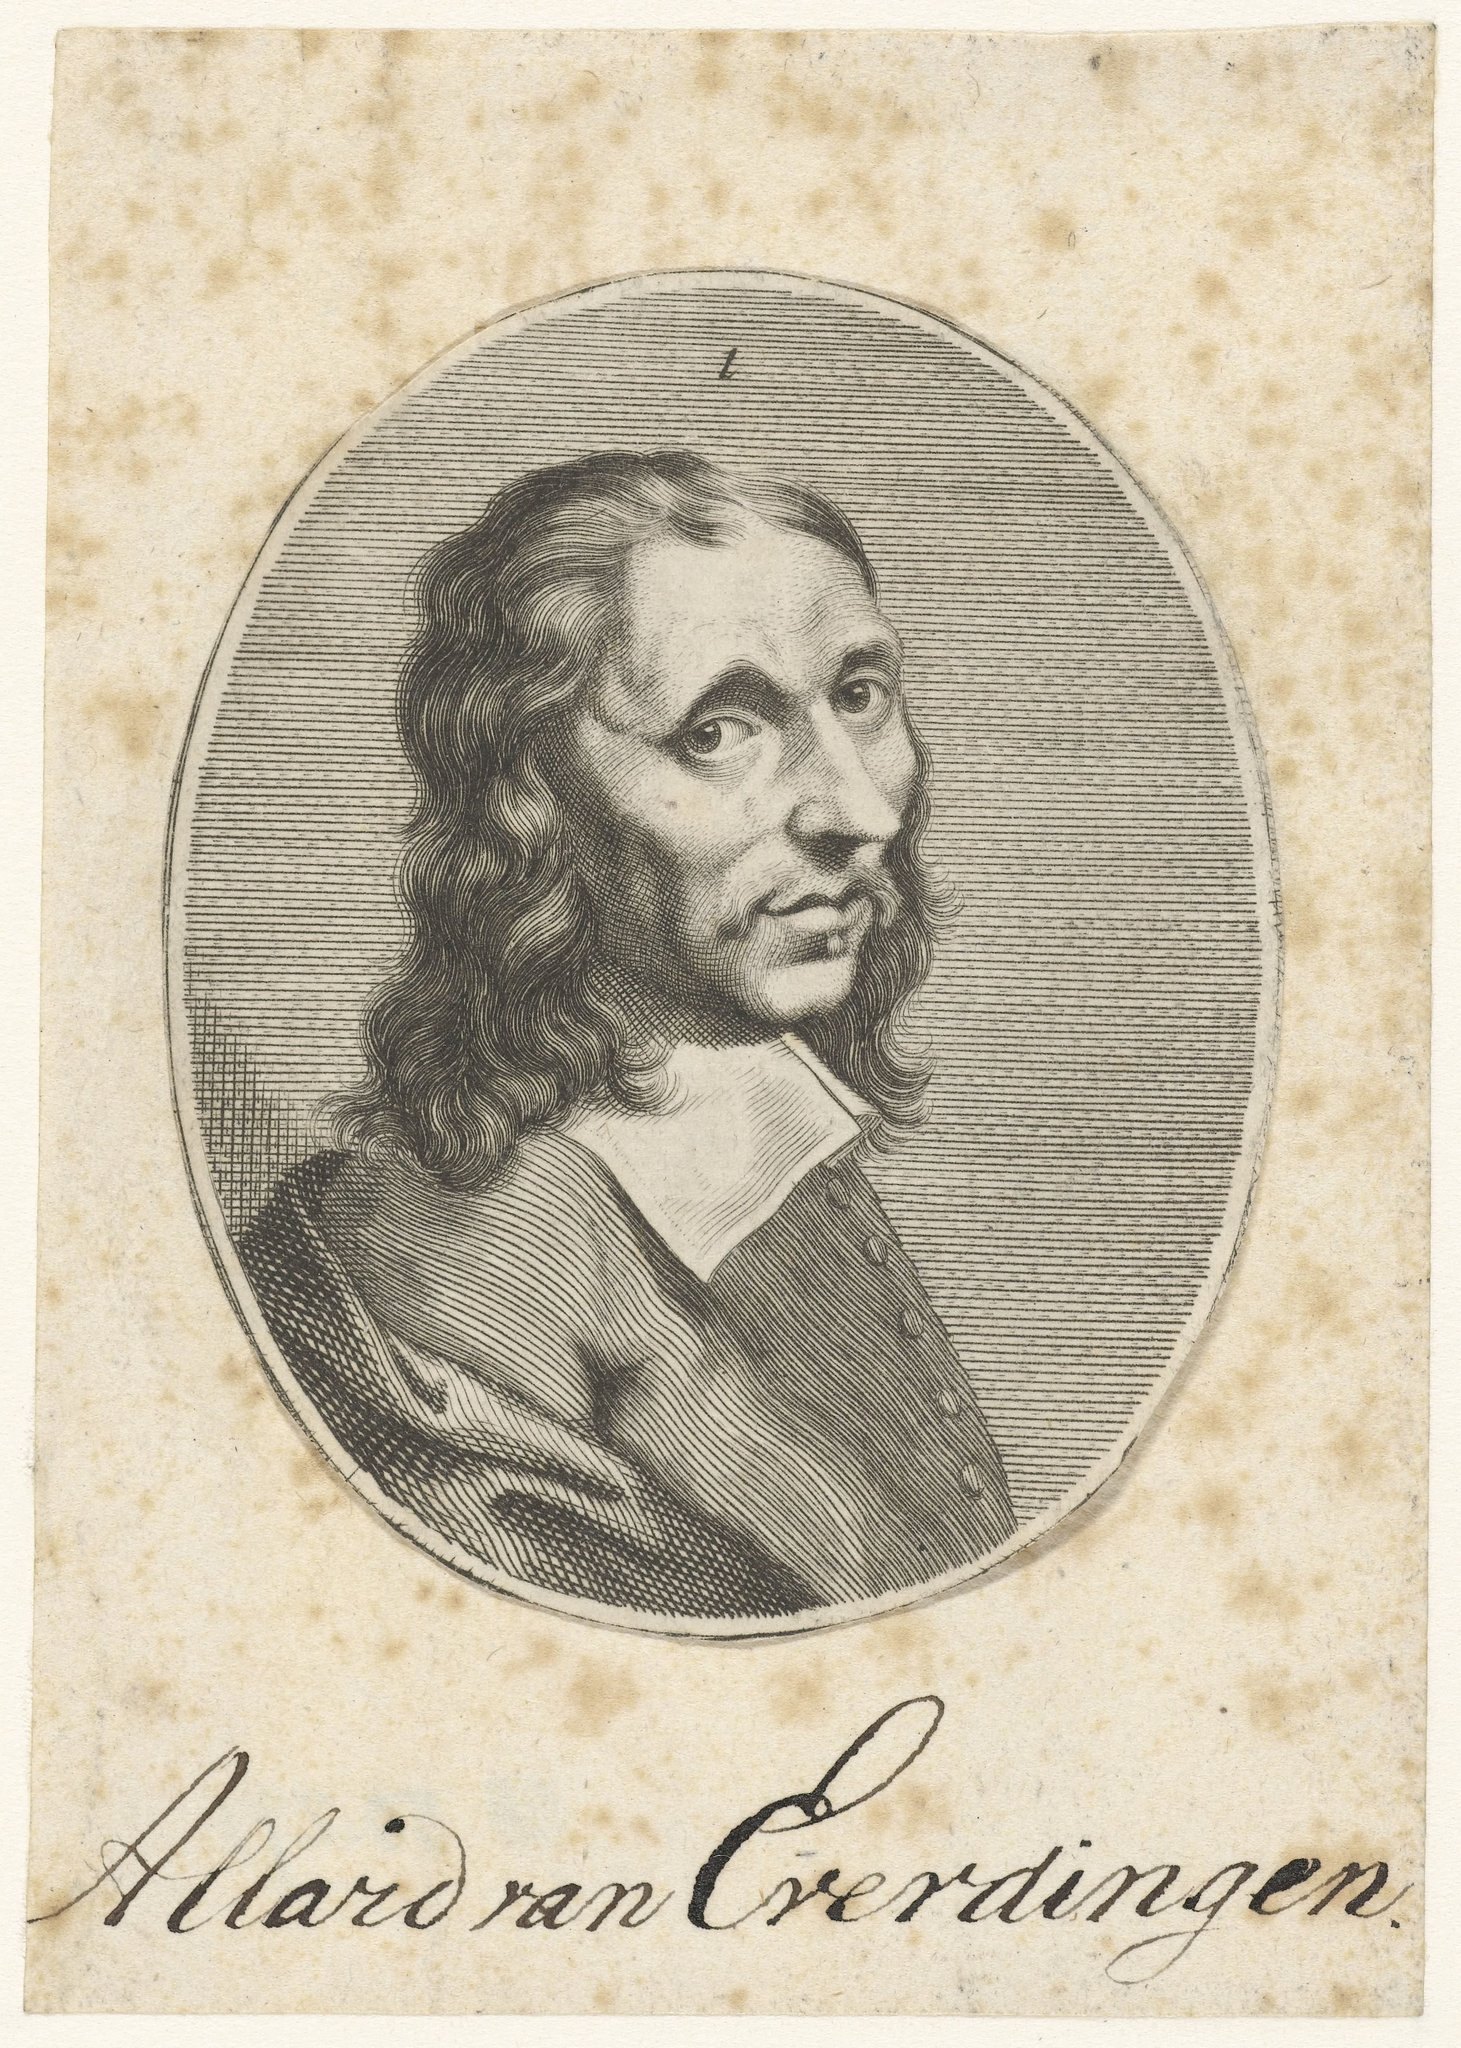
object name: print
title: Portret van Allart van Everdingen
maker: jacob houbraken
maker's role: draughtsman, print maker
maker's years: 1698-1780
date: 1708-1780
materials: paper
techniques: engraving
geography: netherlands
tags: amsterdam, painter, draughtsman, allaert van everdingen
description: Ovaal busteportret van een man met halflang haar. Het portret is op een stukje papier geplakt waarop de naam 'Allard van Everdingen' is geschreven.